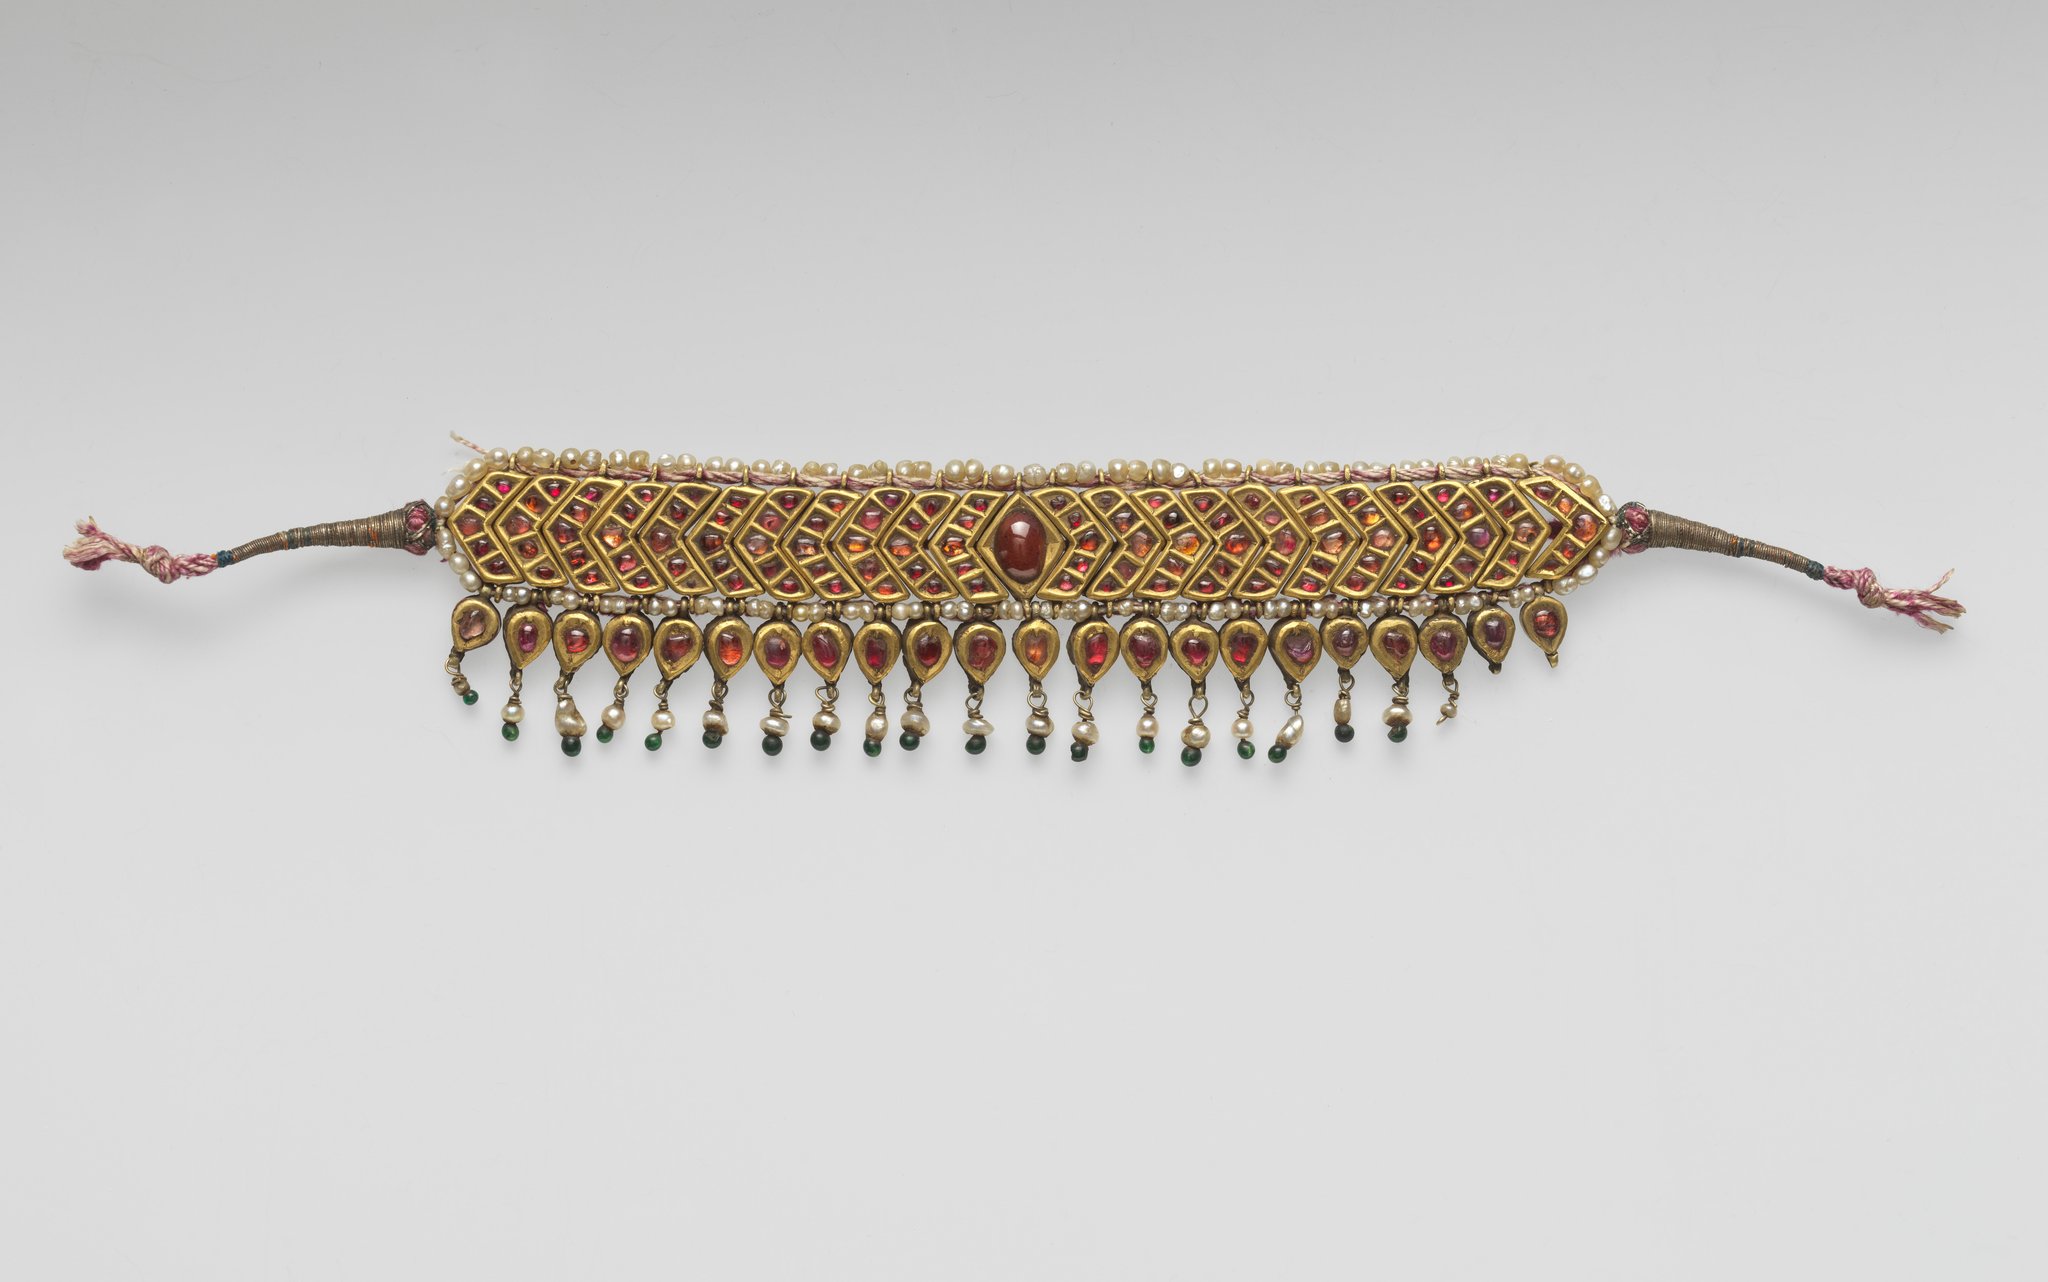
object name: armlet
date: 1801-1900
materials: gold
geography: india